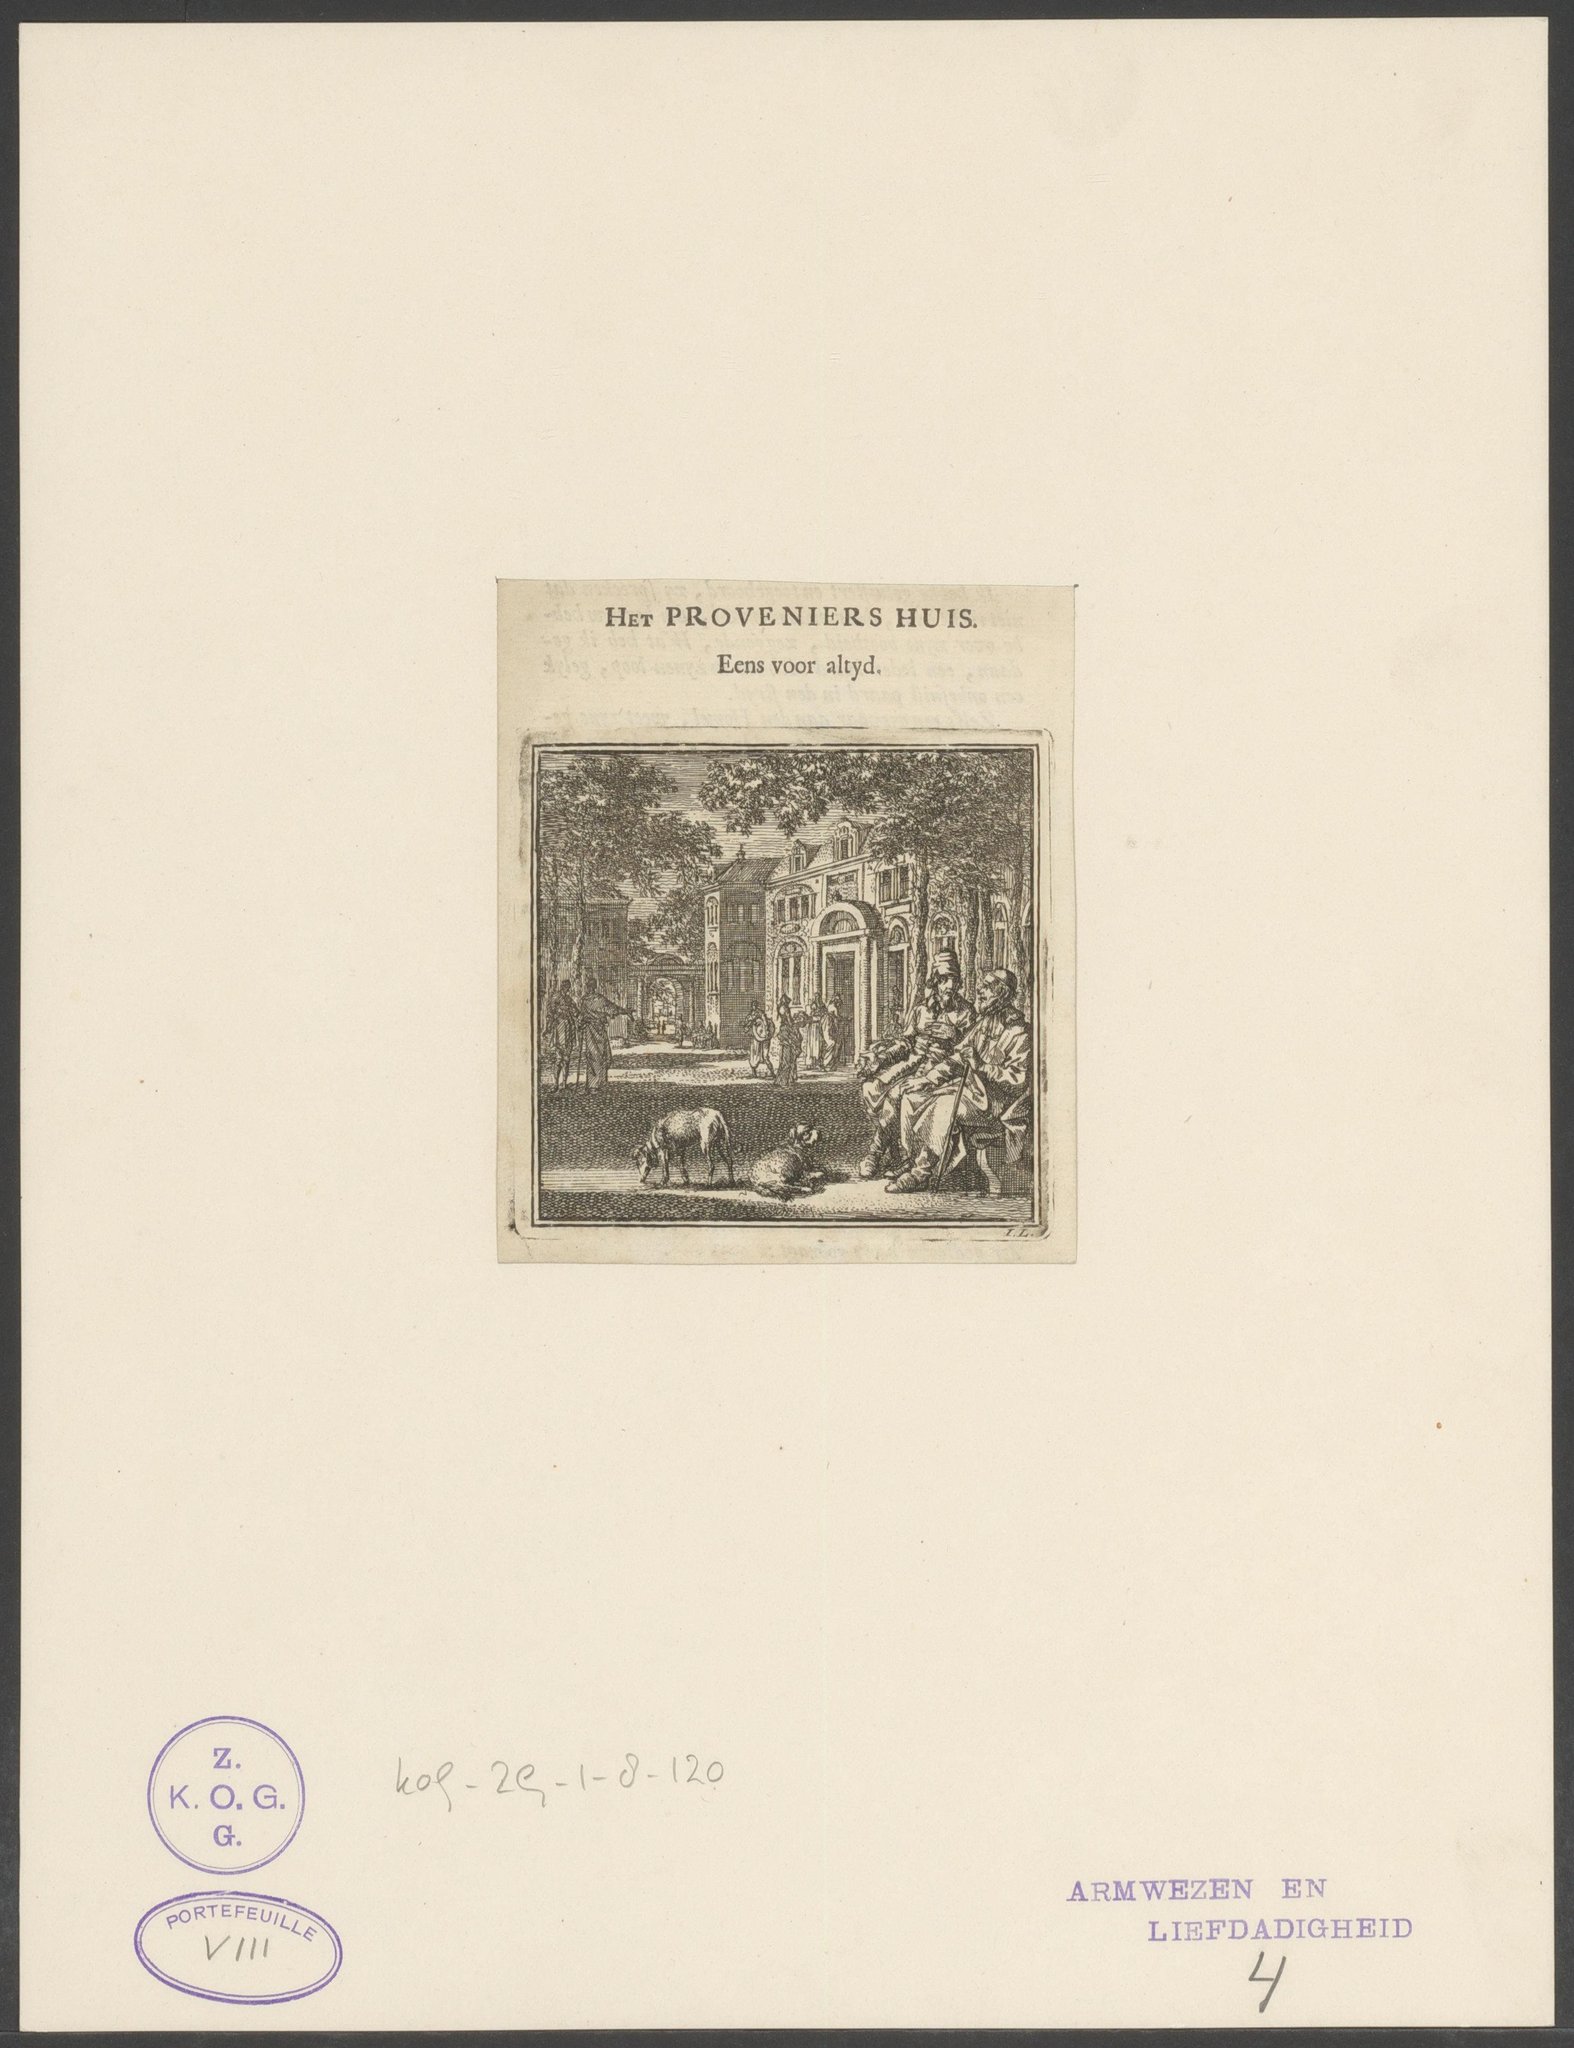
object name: print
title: Het Proveniers Huis. Eens voor altyd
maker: jan luyken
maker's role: draughtsman, print maker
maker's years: 1649-1712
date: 1711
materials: paper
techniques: etching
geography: netherlands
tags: alms-house (dutch: 'hofje'), dog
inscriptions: collector's mark, collector's mark: Lugt 1641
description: Twee bewoners van een proveniershuis zittend op een bankje praten tevreden met elkaar. Voor hen twee honden. Bedrukt met tekst op verso. Onderwerpsrubrieken binnen de Atlas Zeden en Gewoonten: Armwezen en Liefdadigheid.